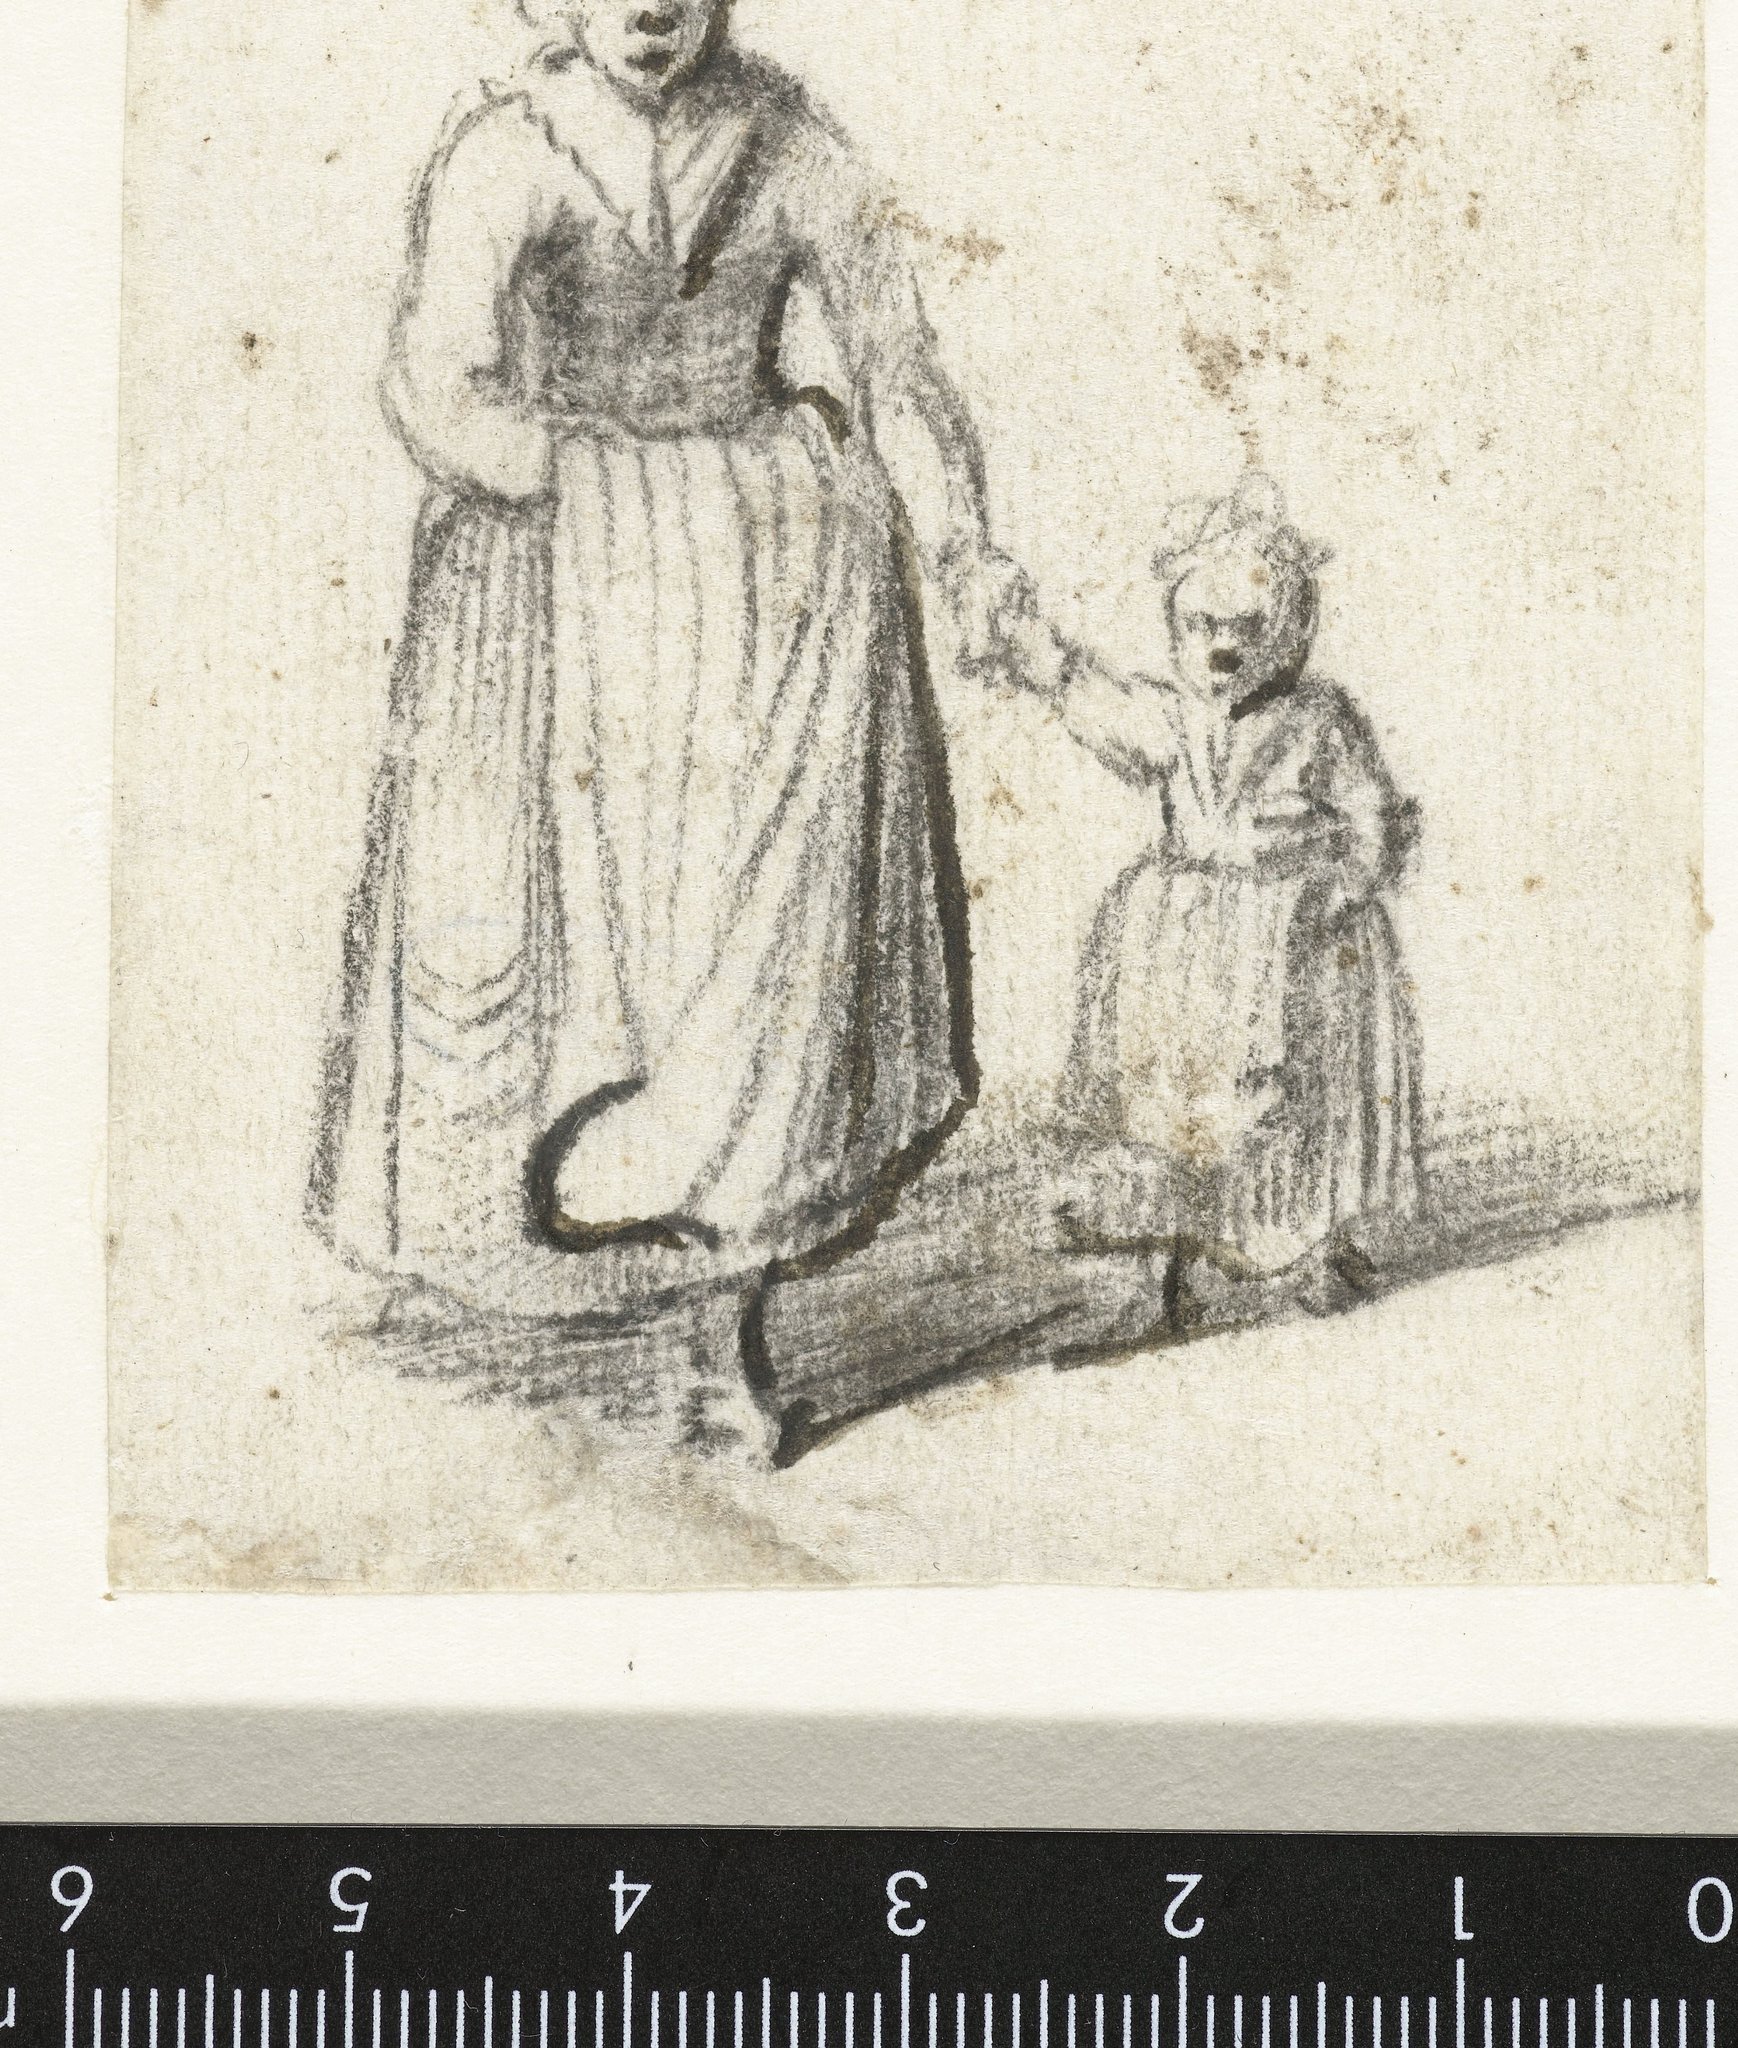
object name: drawing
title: Vrouw lopend met een kind, van voren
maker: harmen ter borch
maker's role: draughtsman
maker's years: 1638-1677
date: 1653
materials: chalk, paper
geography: zwolle